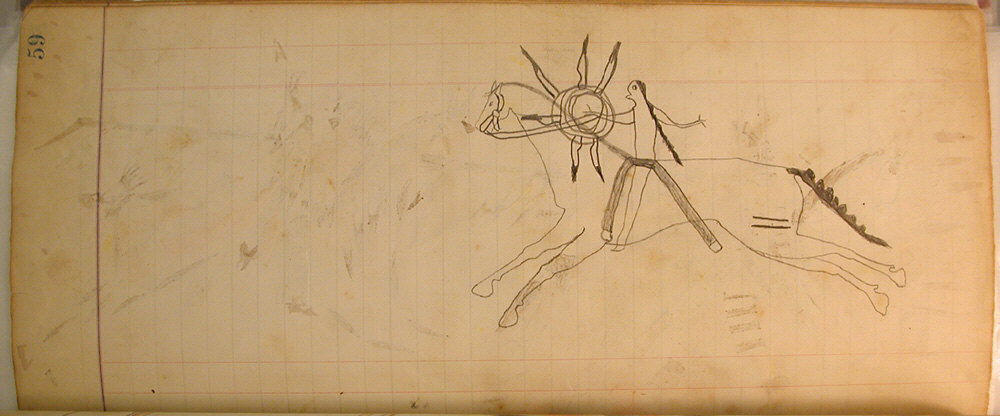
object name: drawing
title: Maffet Ledger: Drawing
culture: cheyenne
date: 1874-1881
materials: crayon, graphite, paper, watercolor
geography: united states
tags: human figures,horses